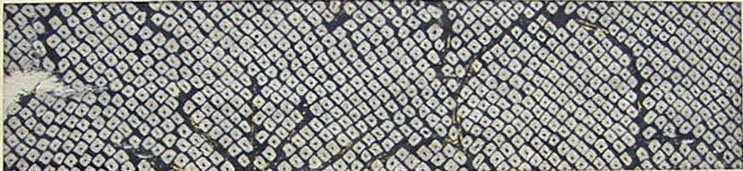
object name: piece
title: Piece from a Kosode with Incomplete Floral Pattern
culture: japanese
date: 1615-1868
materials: gold leaf, silk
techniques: damask, dyeing, resist